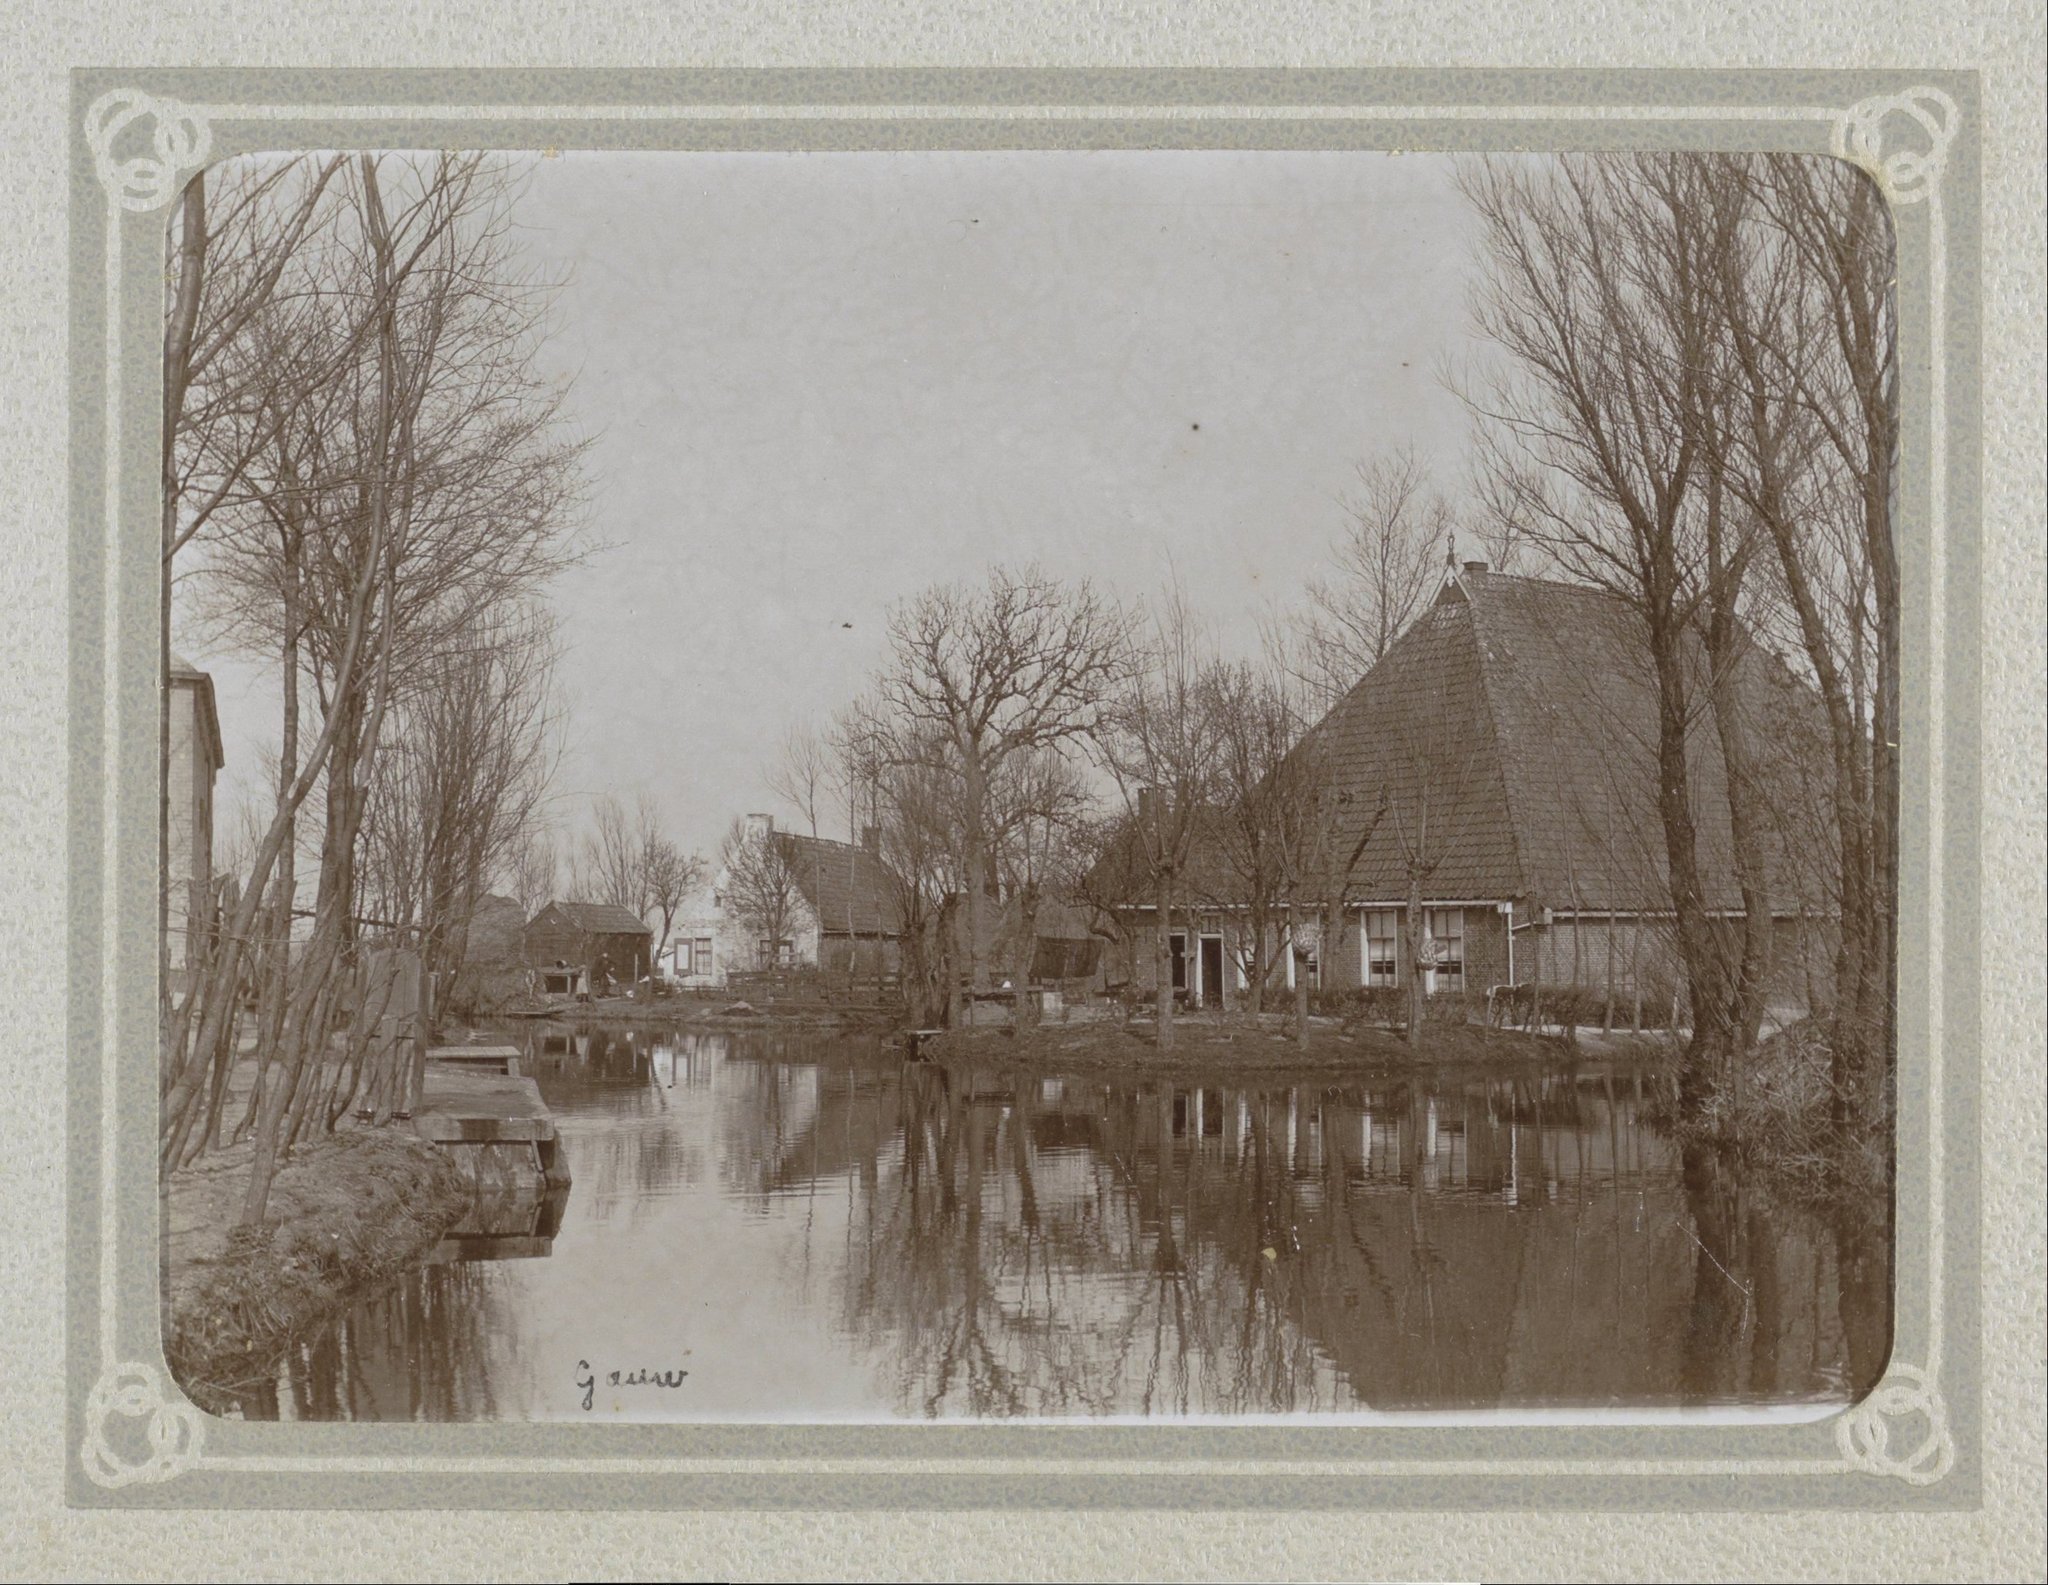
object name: photograph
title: Grouw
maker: folkert idzes de jong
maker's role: architect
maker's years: 1877-1929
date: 1905-1907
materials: photographic support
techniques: collodion silver print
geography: grouw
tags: village, small canal, ditch, farm (building)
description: Onderdeel van Topografisch album van Nederlandse dorpen en steden 1905.